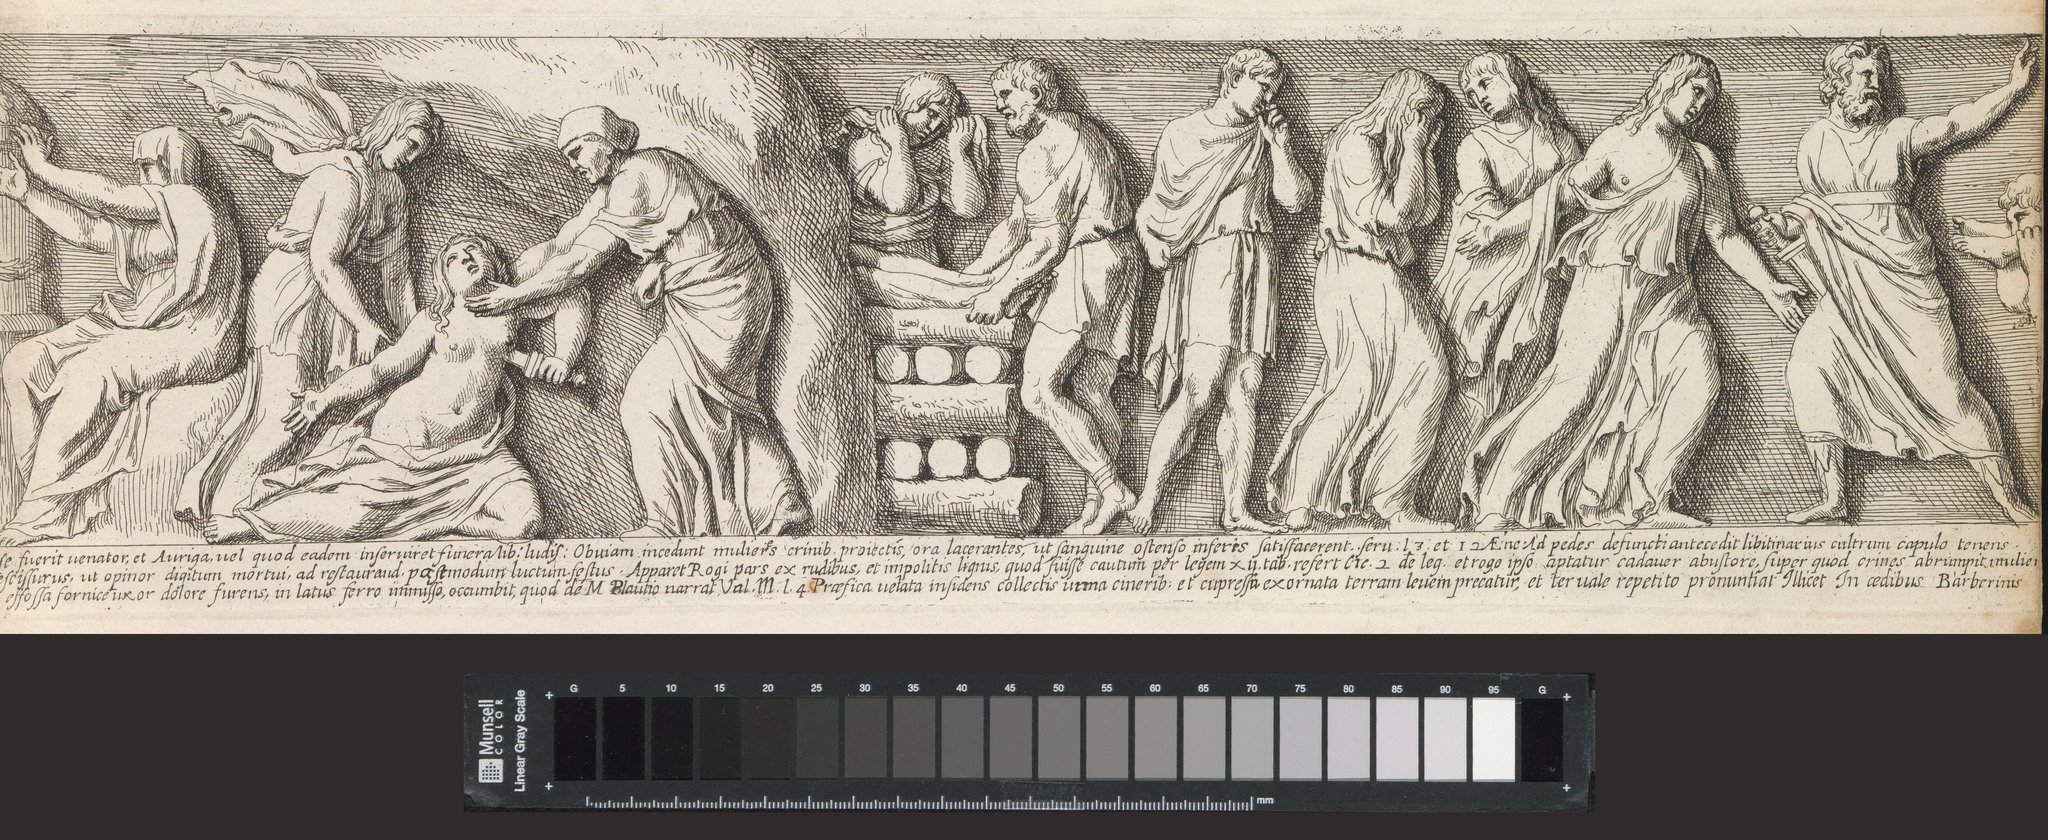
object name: album leaf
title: Reliëf met een naakte vrouw die zelfmoord pleegt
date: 1645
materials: paper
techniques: etching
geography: vatican city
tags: piece of sculpture, reproduction of a piece of sculpture, seeking death, suicide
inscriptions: inscription: ‘Ende No. 22./ op folio 4[...]9.’, number: ‘27’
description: Reliëf met links een naakte vrouw die zichzelf steekt met een dolk. Twee vrouwen ondersteunen haar. Rechts een groep figuren, waaronder een treurende vrouw. Tekst in het Latijn in ondermarge. Prent maakt deel uit van een album.